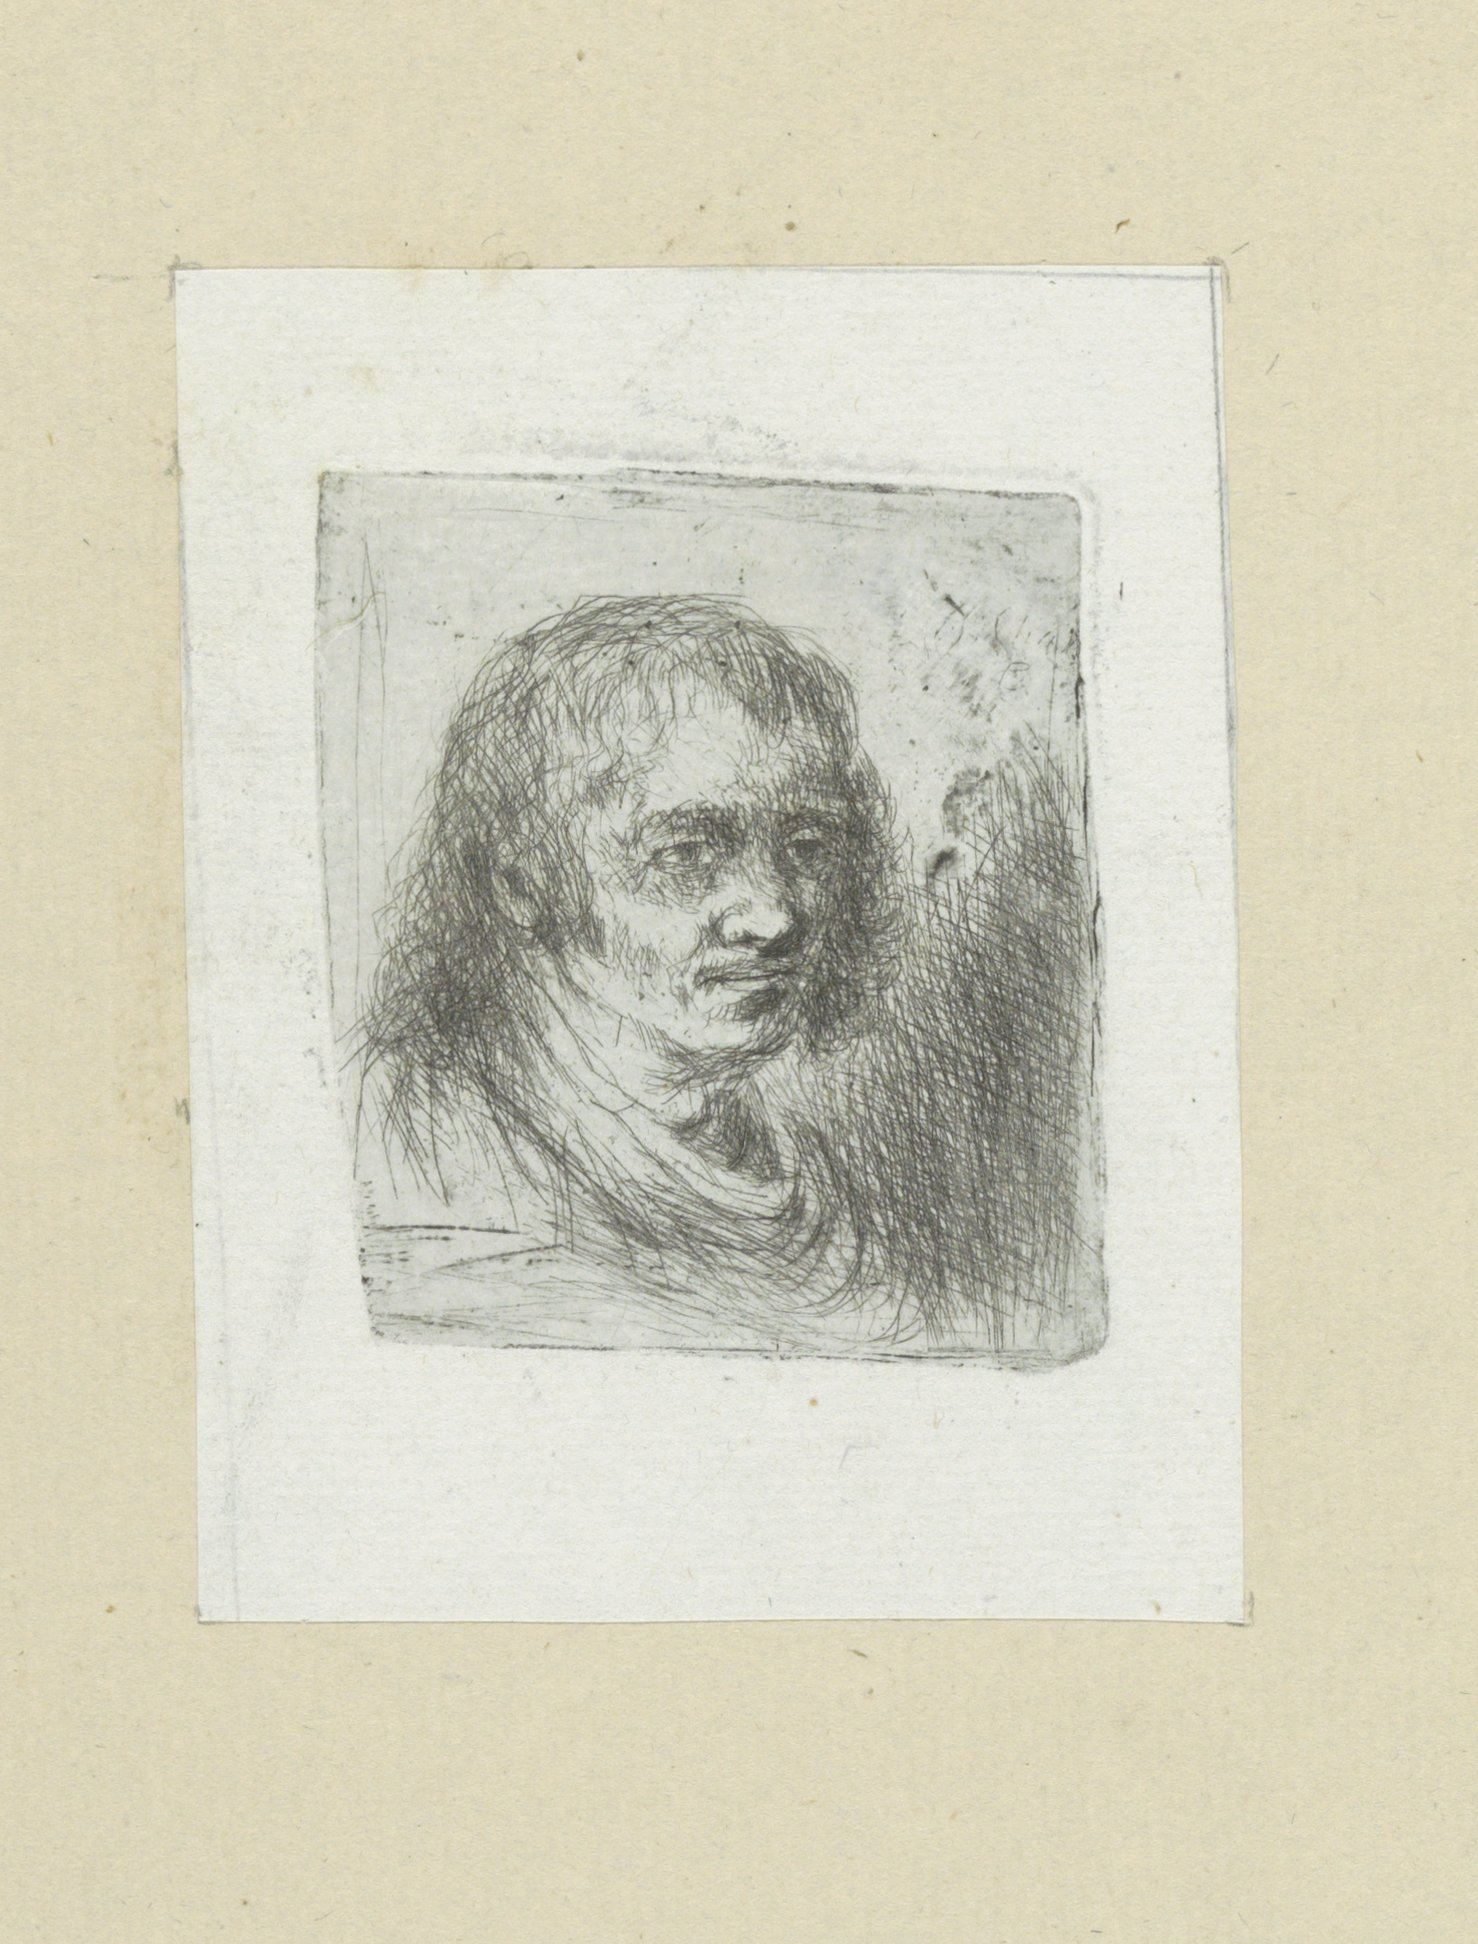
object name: album leaf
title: The Compleat Work of Etchings by John Chalon / Oeuvre Complette des Eaux Fortes par Jean Chalon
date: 1802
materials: paper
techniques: drypoint, etching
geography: london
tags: morphology of human expression (+ adult female (human being))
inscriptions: collector's mark: ‘B’, collector's mark: ‘RIJKS / MUSM’